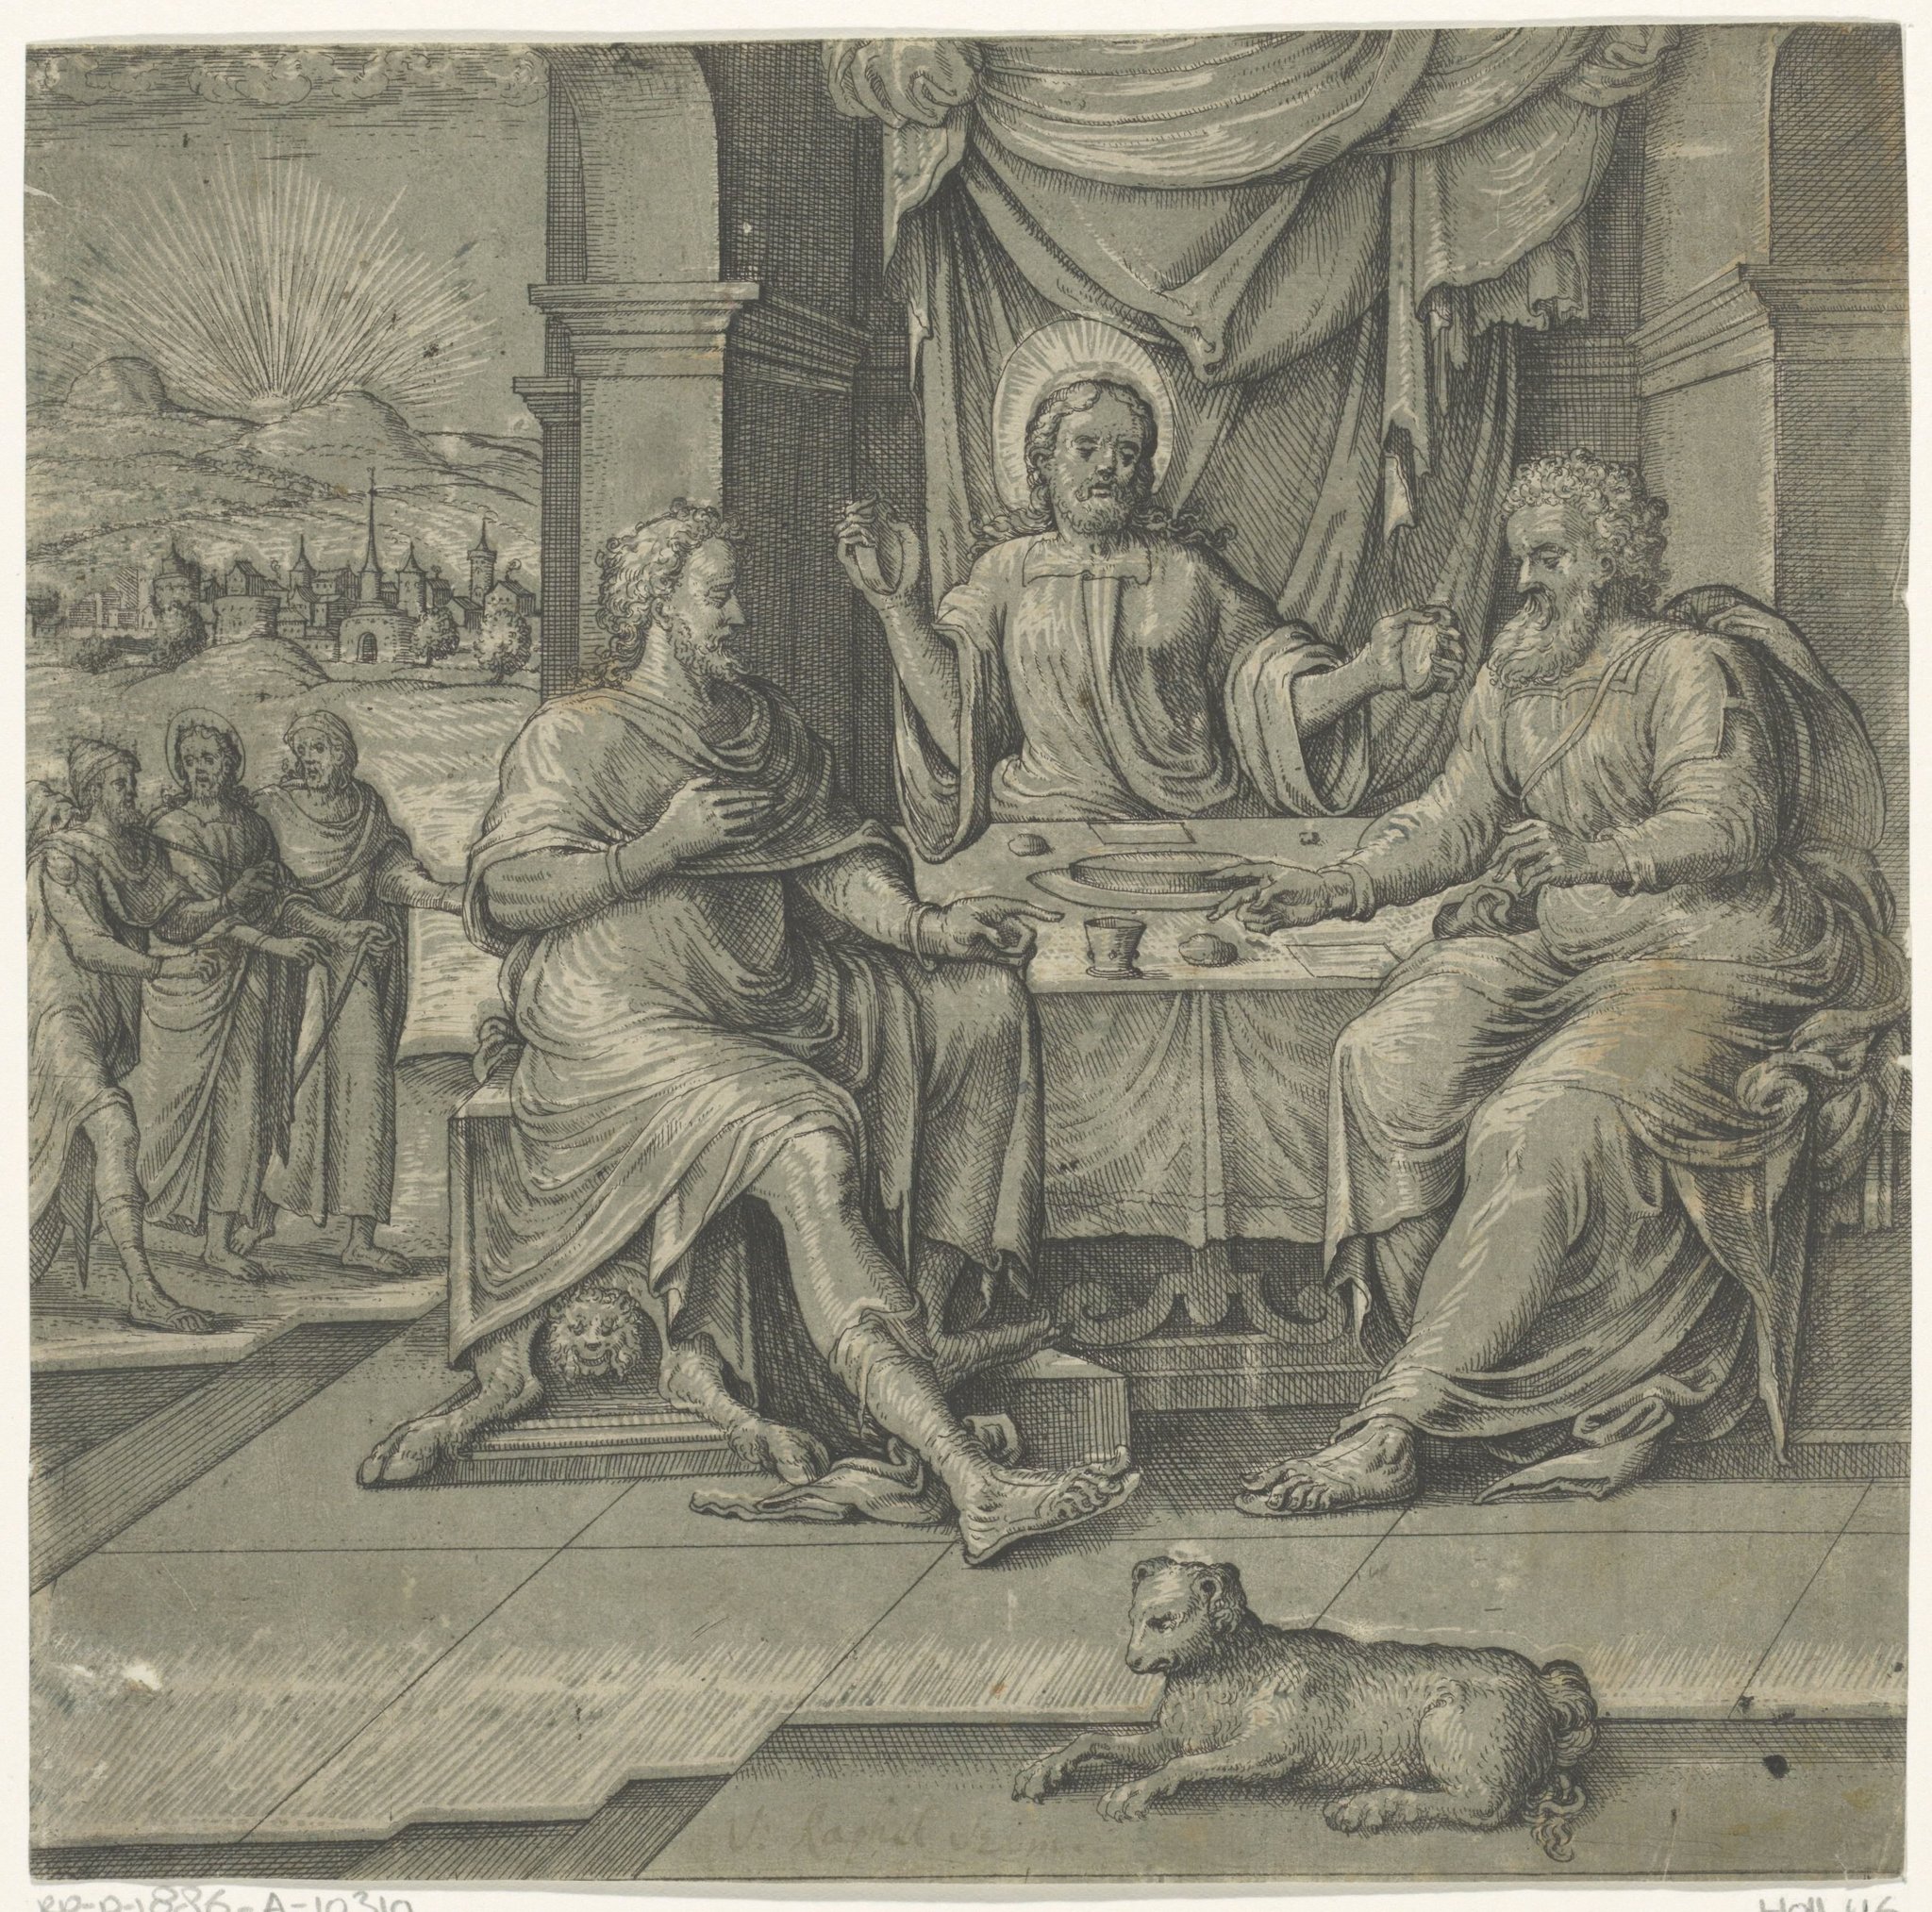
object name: print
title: Maaltijden van Christus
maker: Anonymous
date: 1570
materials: paper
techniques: woodcut, etching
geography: antwerp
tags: the supper at emmaus: christ is recognized while blessing or breaking the bread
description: Christus zit met de Emmaüsgangers aan tafel en breekt het brood. Op de voorgrond ligt een hond. Op de achtergrond loopt Christus met de twee discipelen naar Emmaüs.